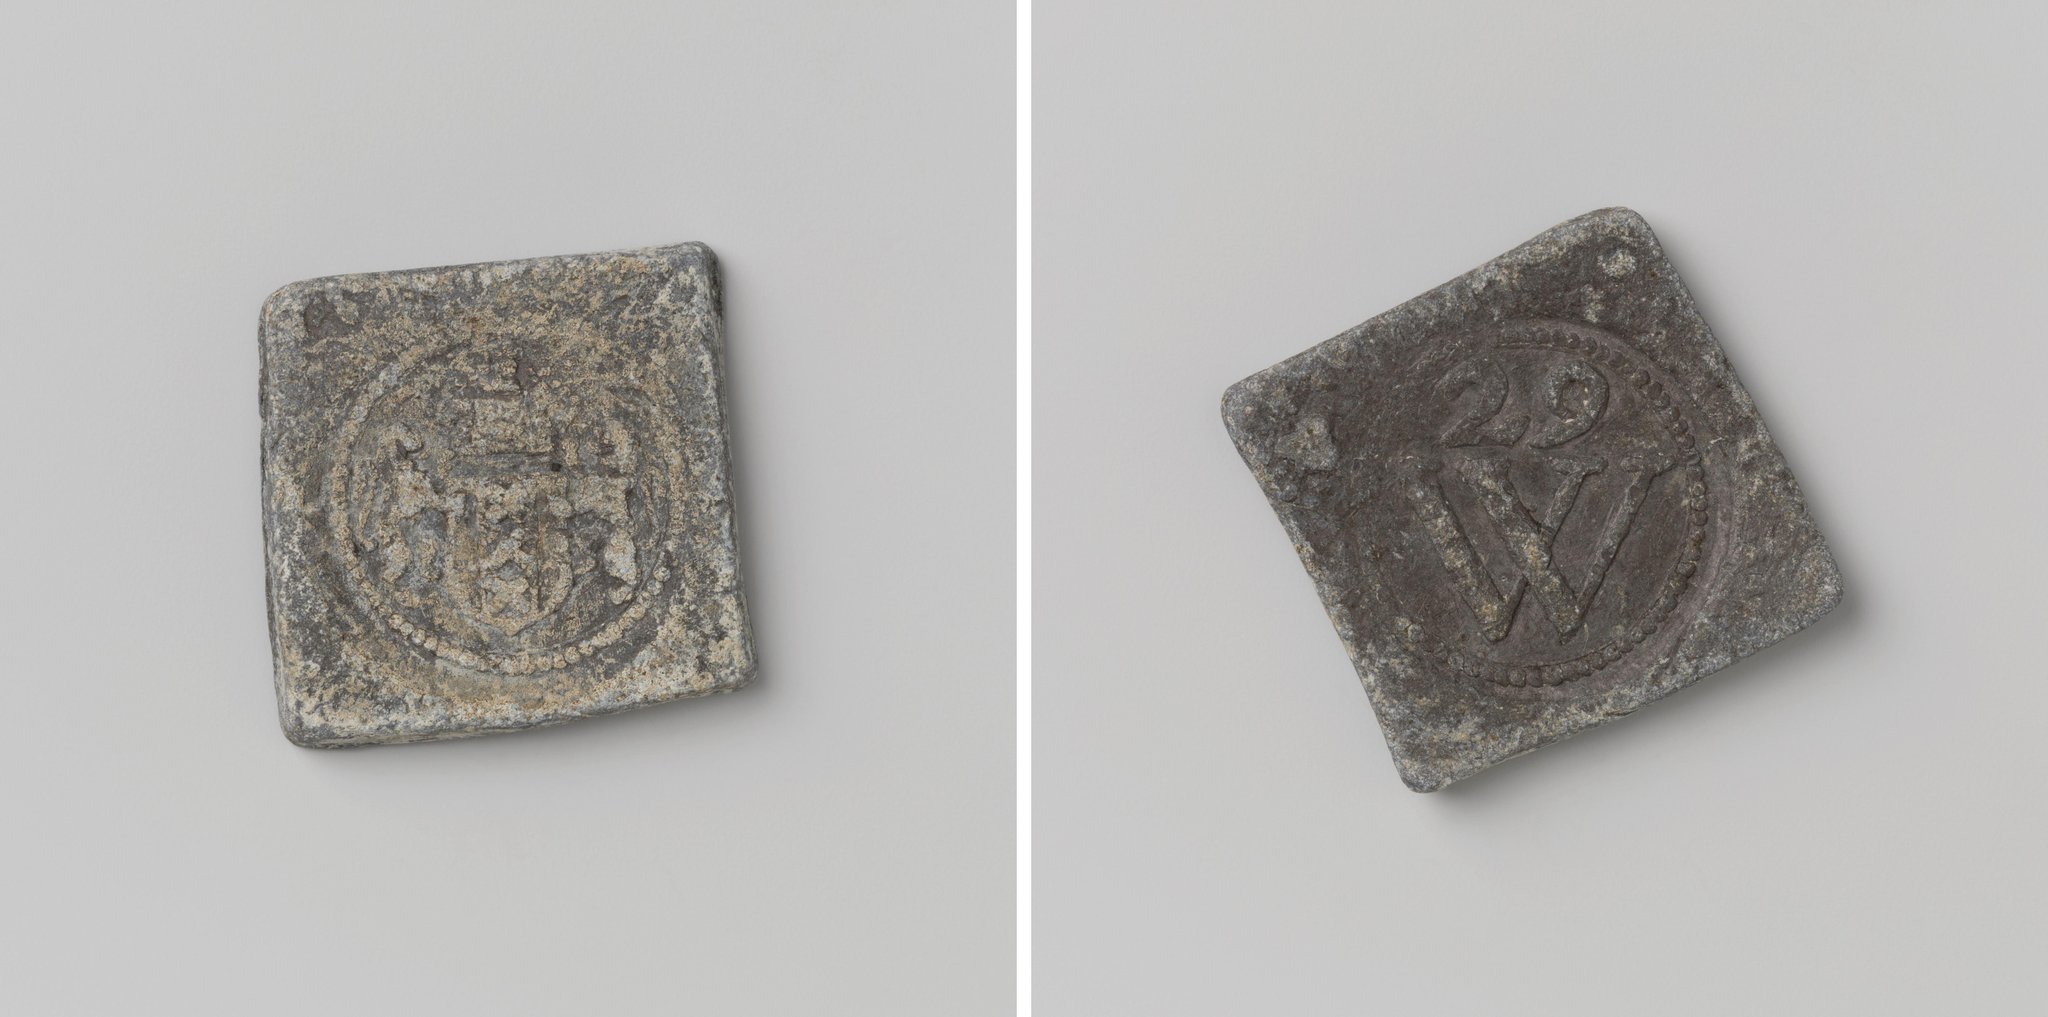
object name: alms token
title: Stad Amsterdam, wijk 29, penning die recht gaf op roggebrood tegen een prijs van achteneenhalve stuiver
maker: Anonymous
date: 1662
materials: lead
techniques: casting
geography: amsterdam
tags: amsterdam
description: bijna ruitvormige penning. Voorzijde: in ronde stempel: gekroond wapenschild, geflankeerd door twee leeuwen binnen ronde parelrand. Keerzijde: in ronde stempel: cijfer 29 boven letter W binnen ronde parelrand